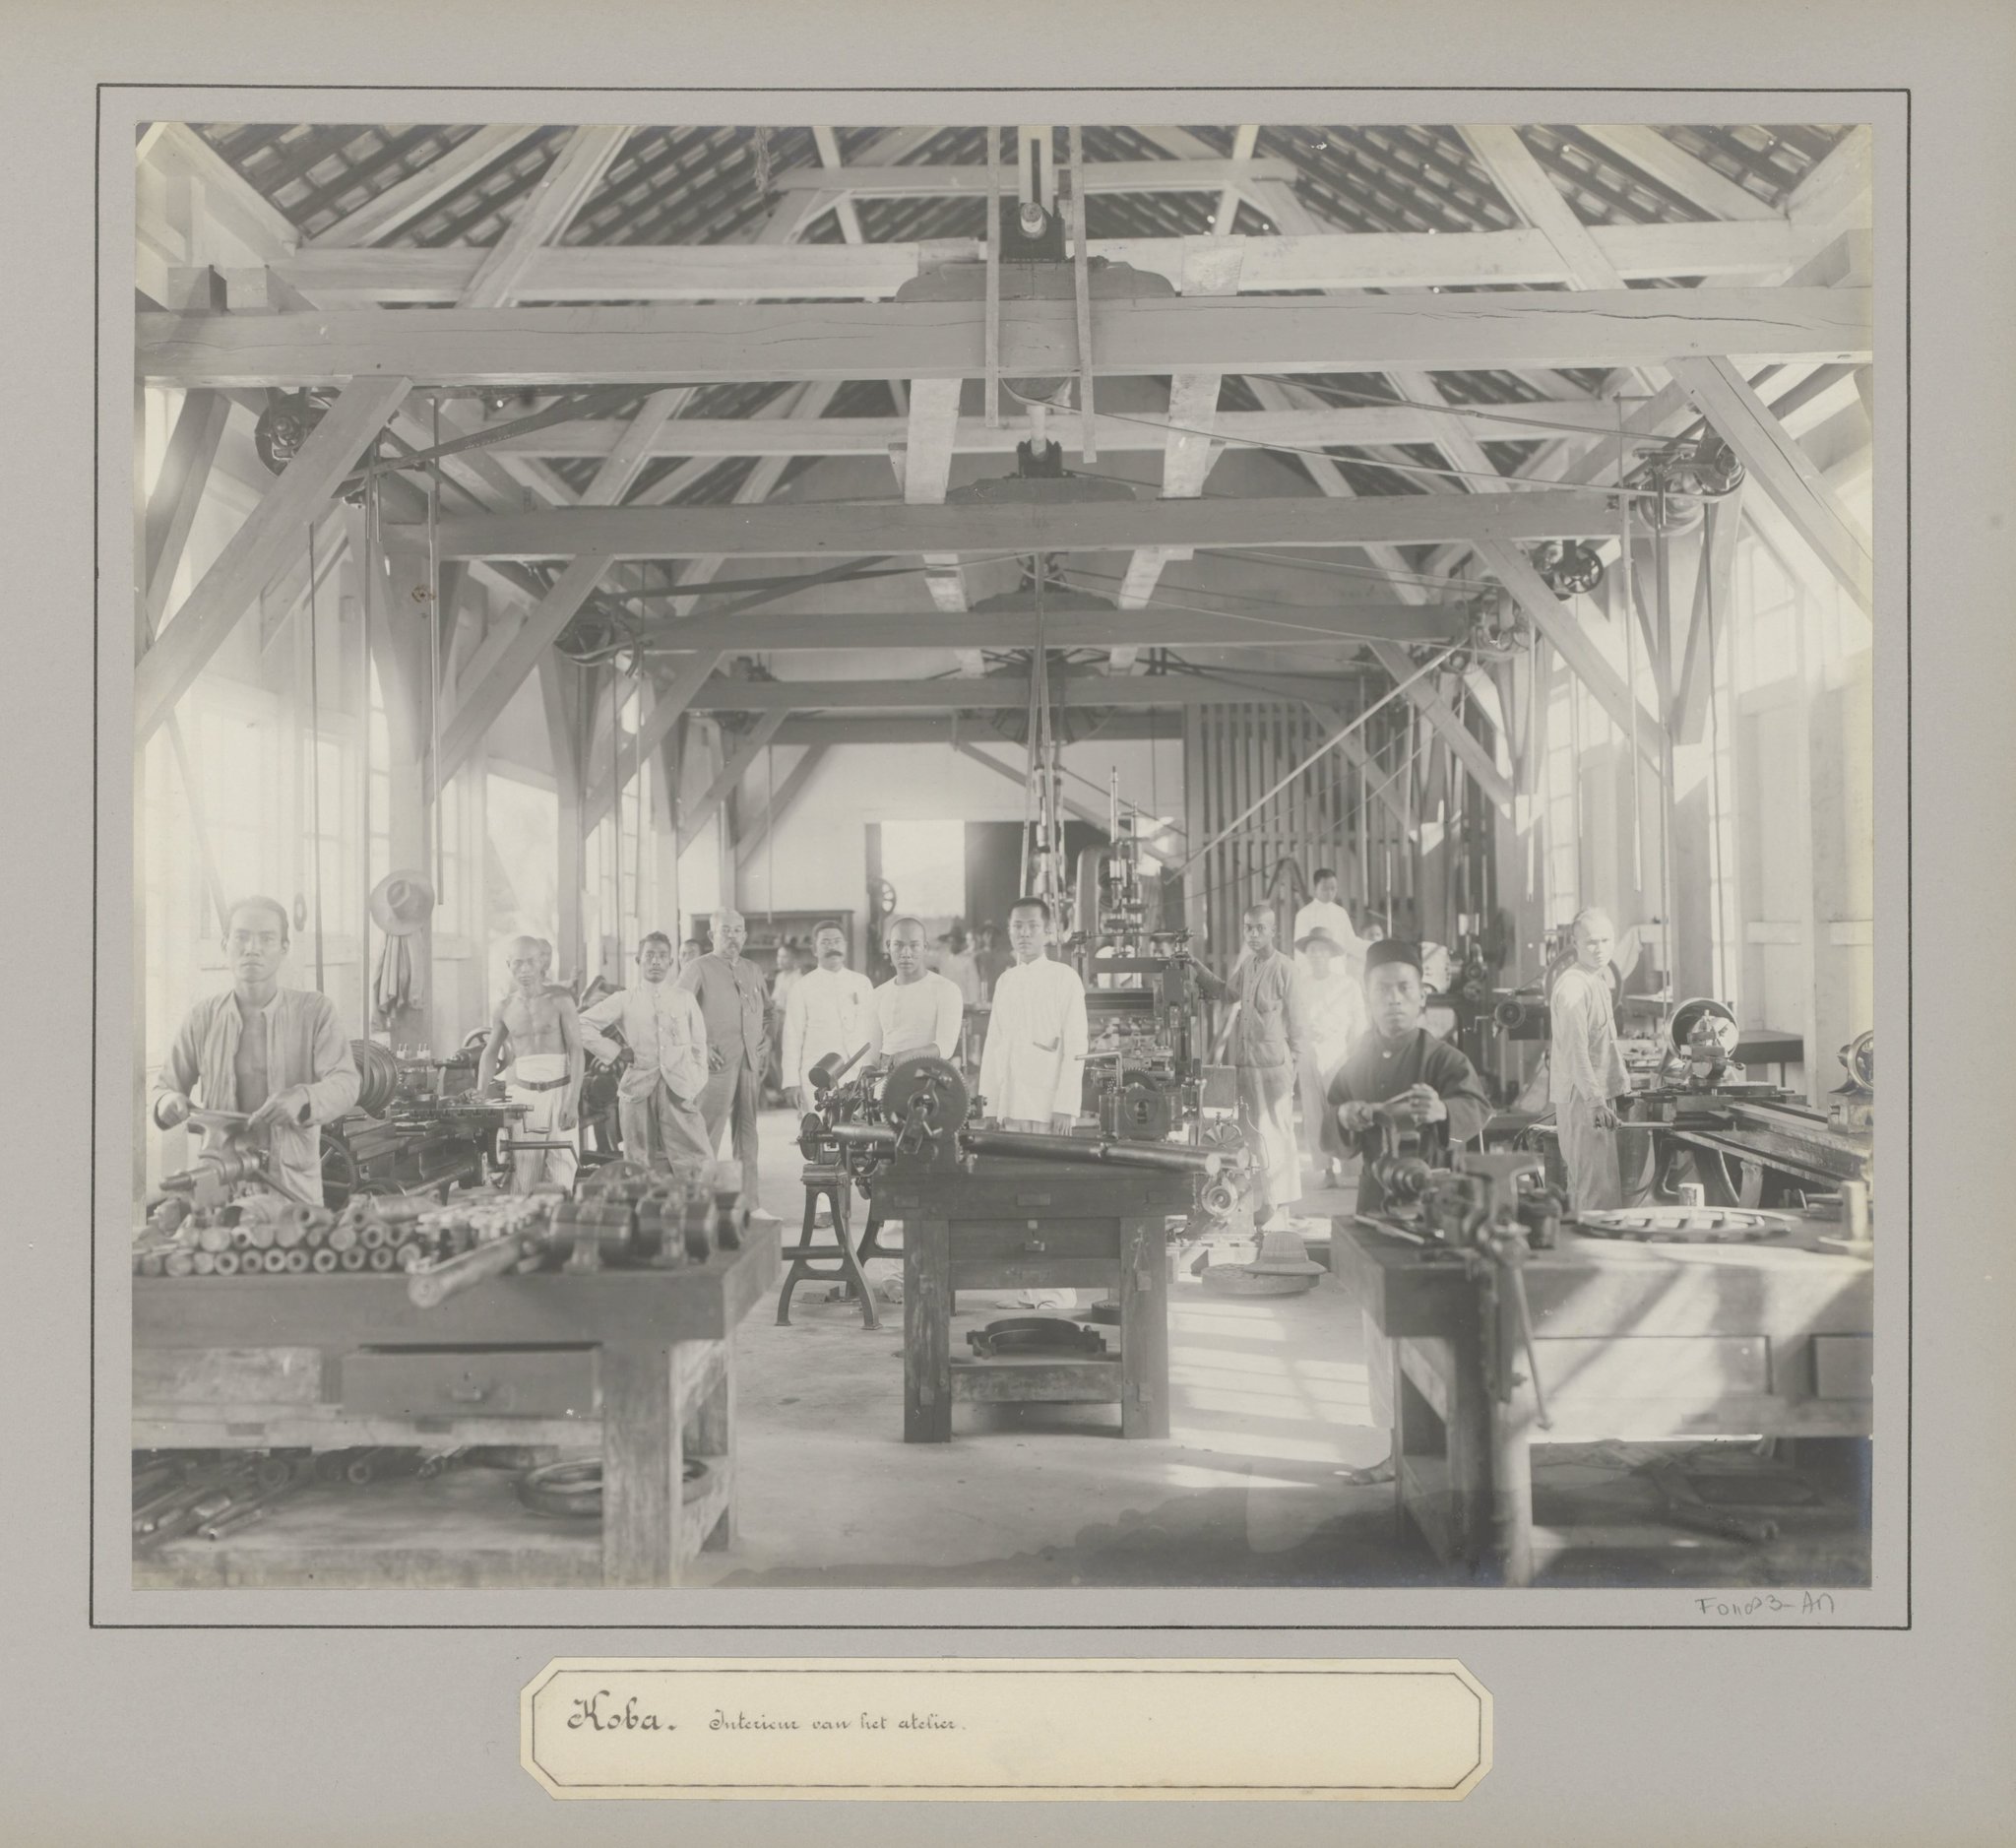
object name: photograph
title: Werknemers poserend in een werkplaats van een tinonderneming te Koba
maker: Anonymous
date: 1900-1920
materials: photographic support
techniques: gelatin silver print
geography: koba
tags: mining, minerals and metals: tin, working class, labourers, workshop-interior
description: Onderdeel van Fotoalbum over de tinwinning op Bangka.